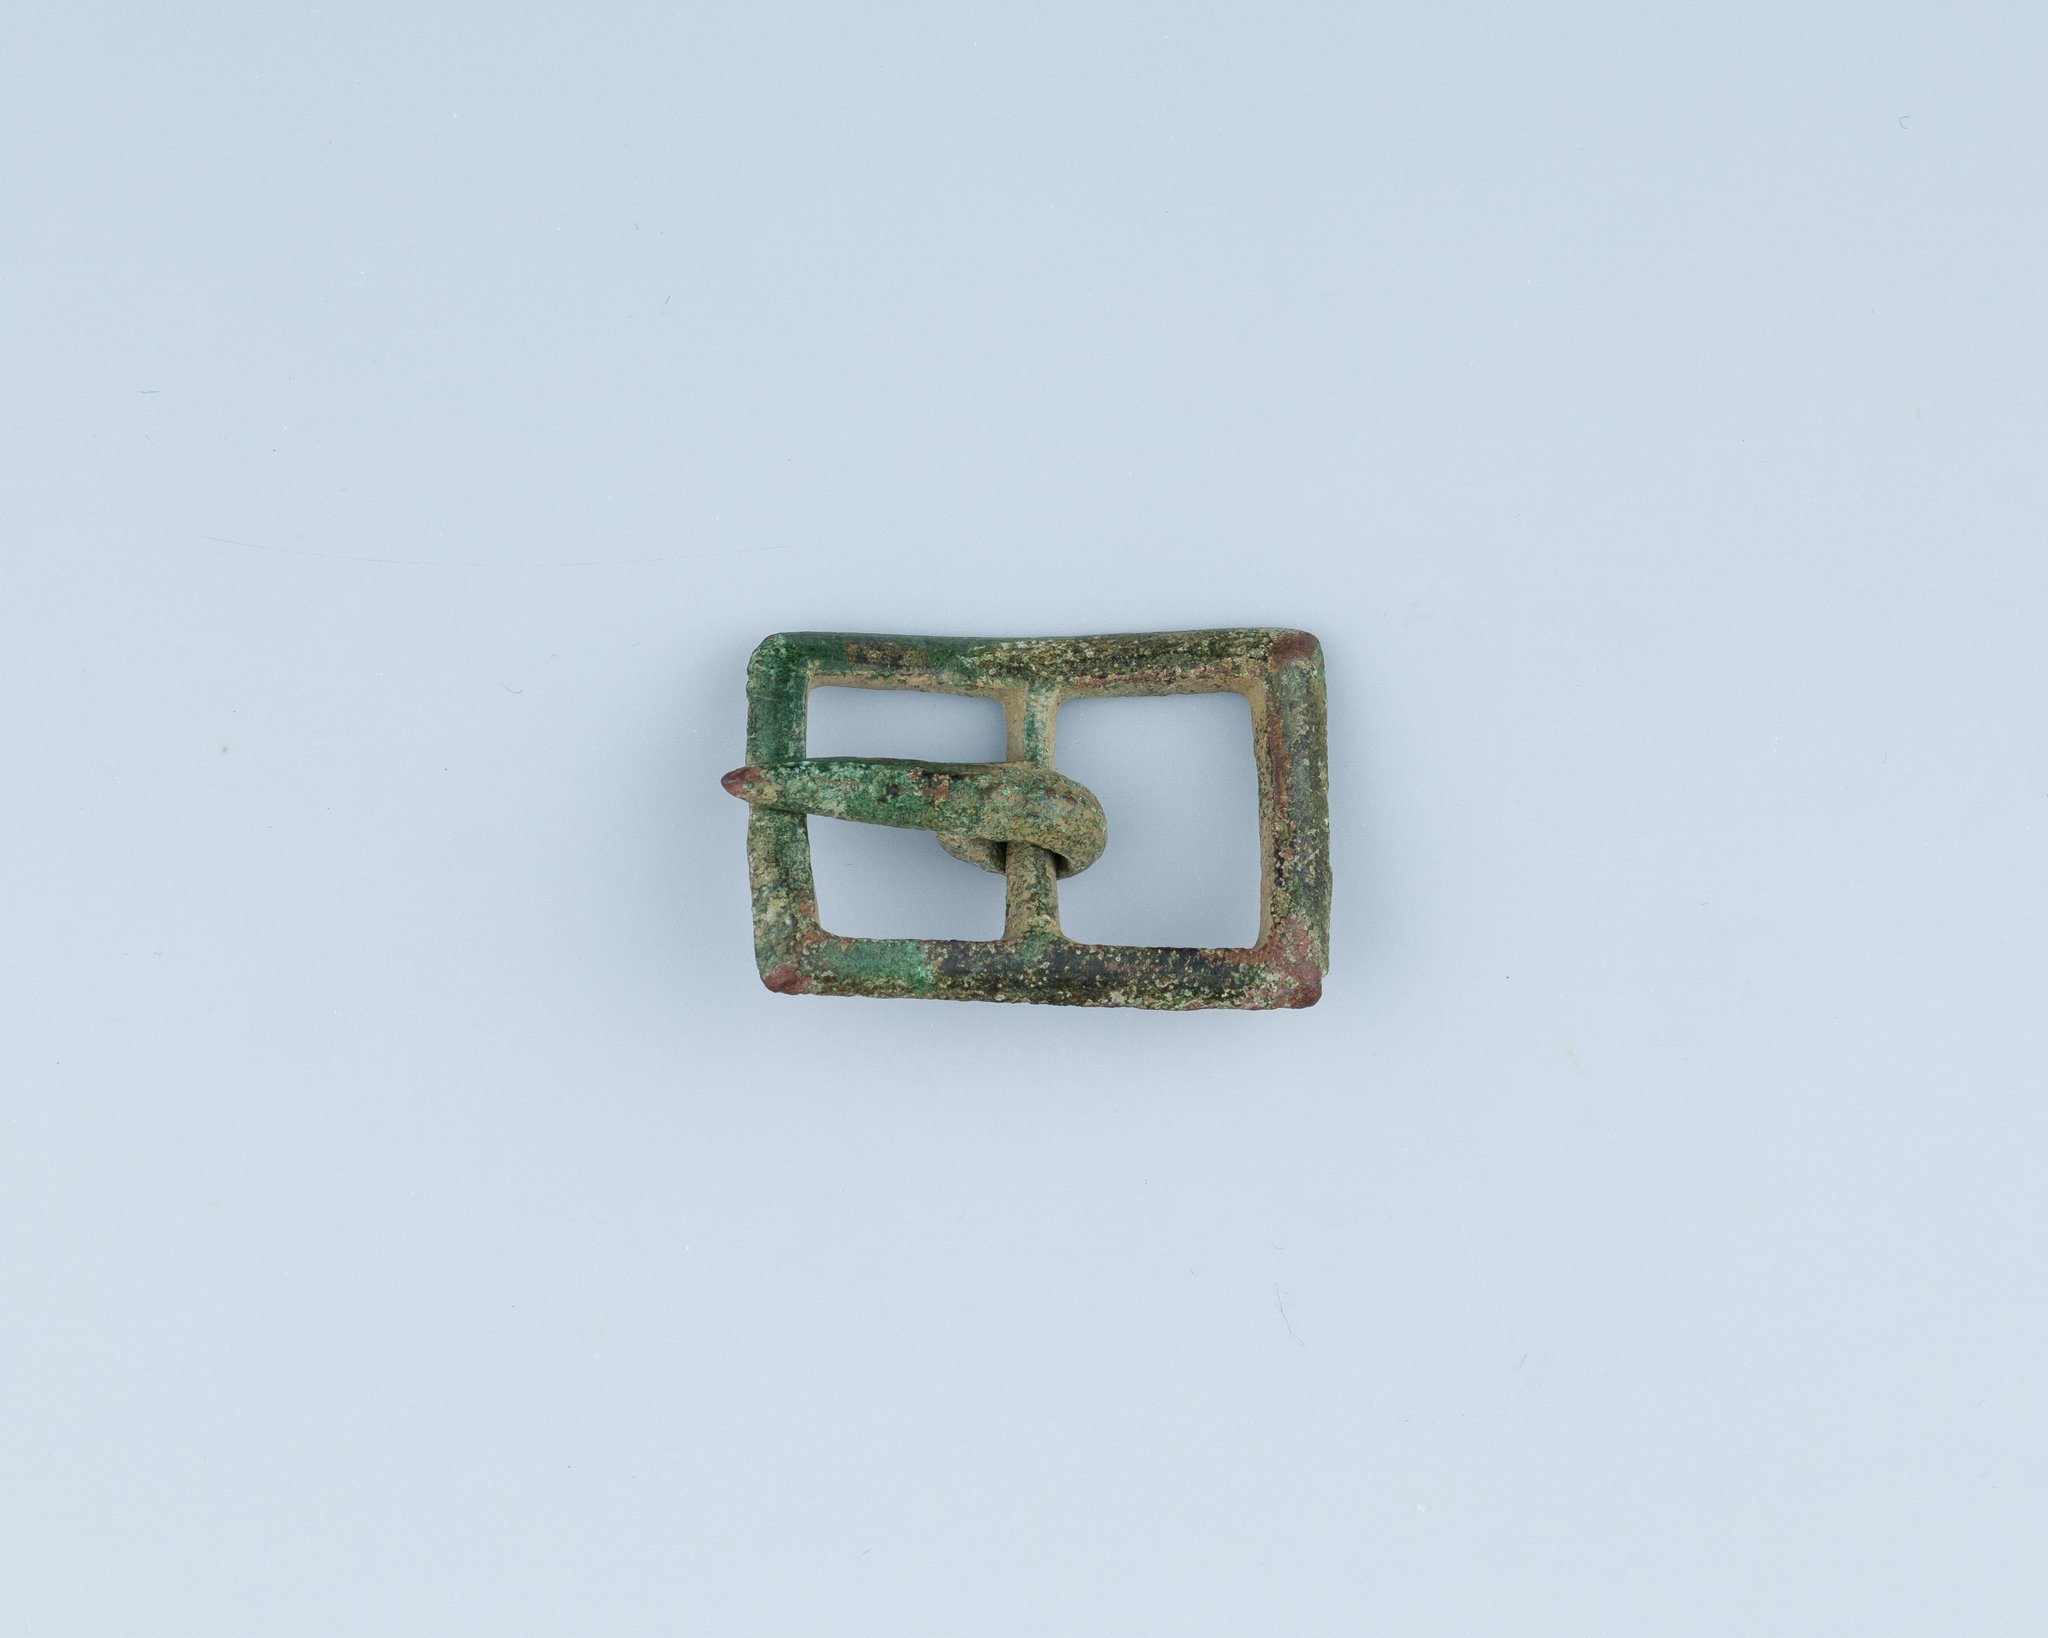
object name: buckle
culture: european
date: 1401-1600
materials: bronze, patina